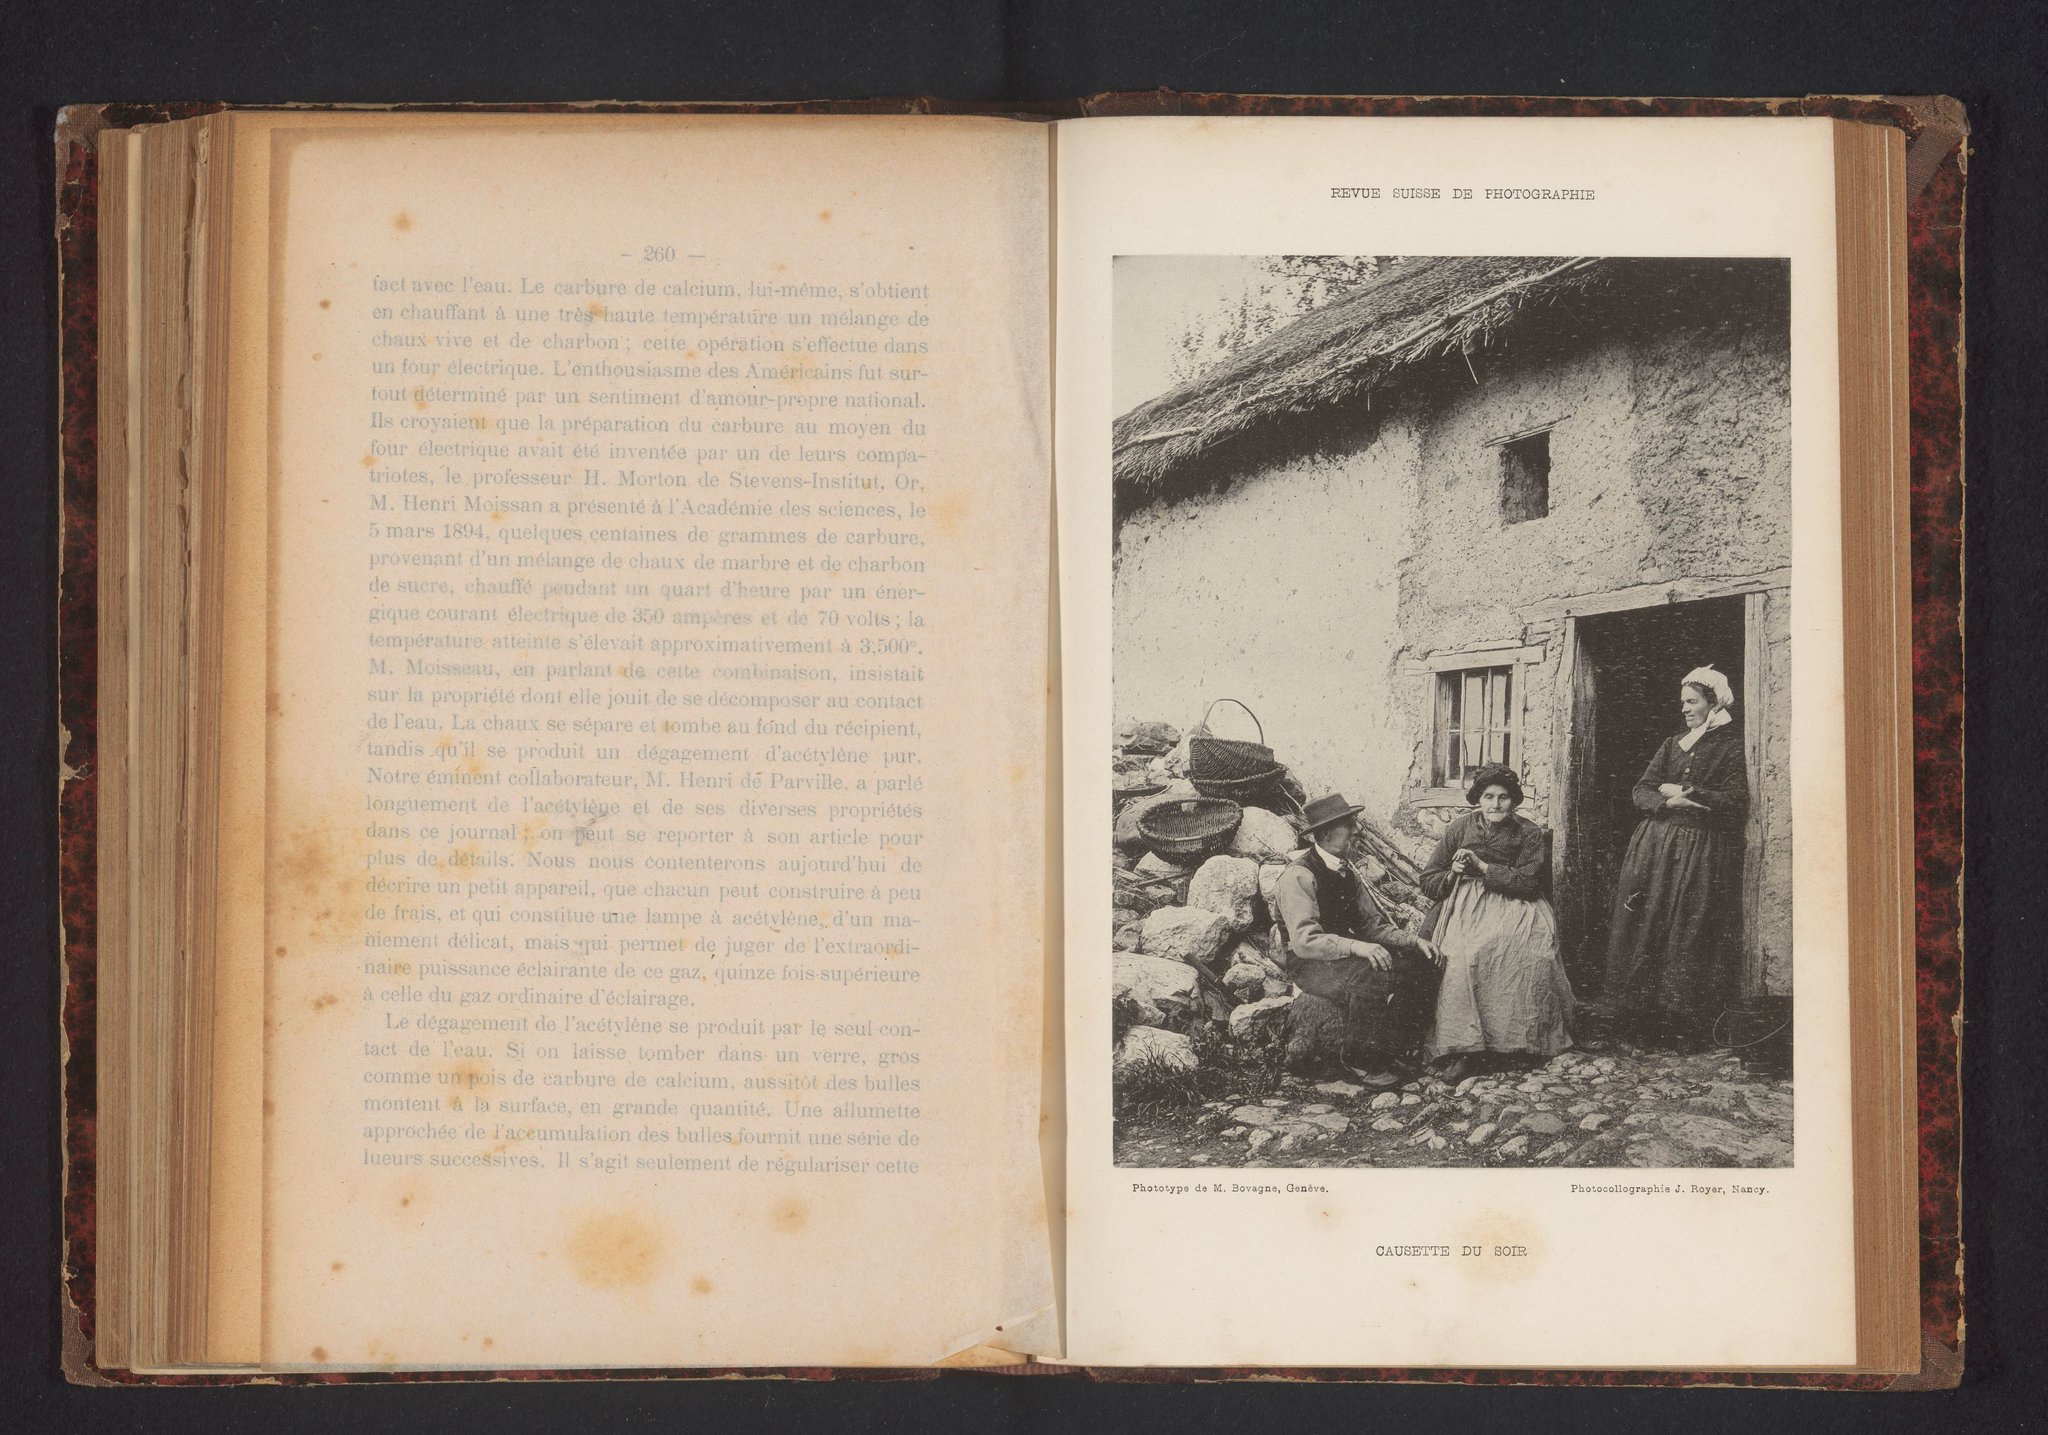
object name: photomechanical print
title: Causette du soir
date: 1890-1895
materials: paper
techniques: photograph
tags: adult woman, open door, adult man